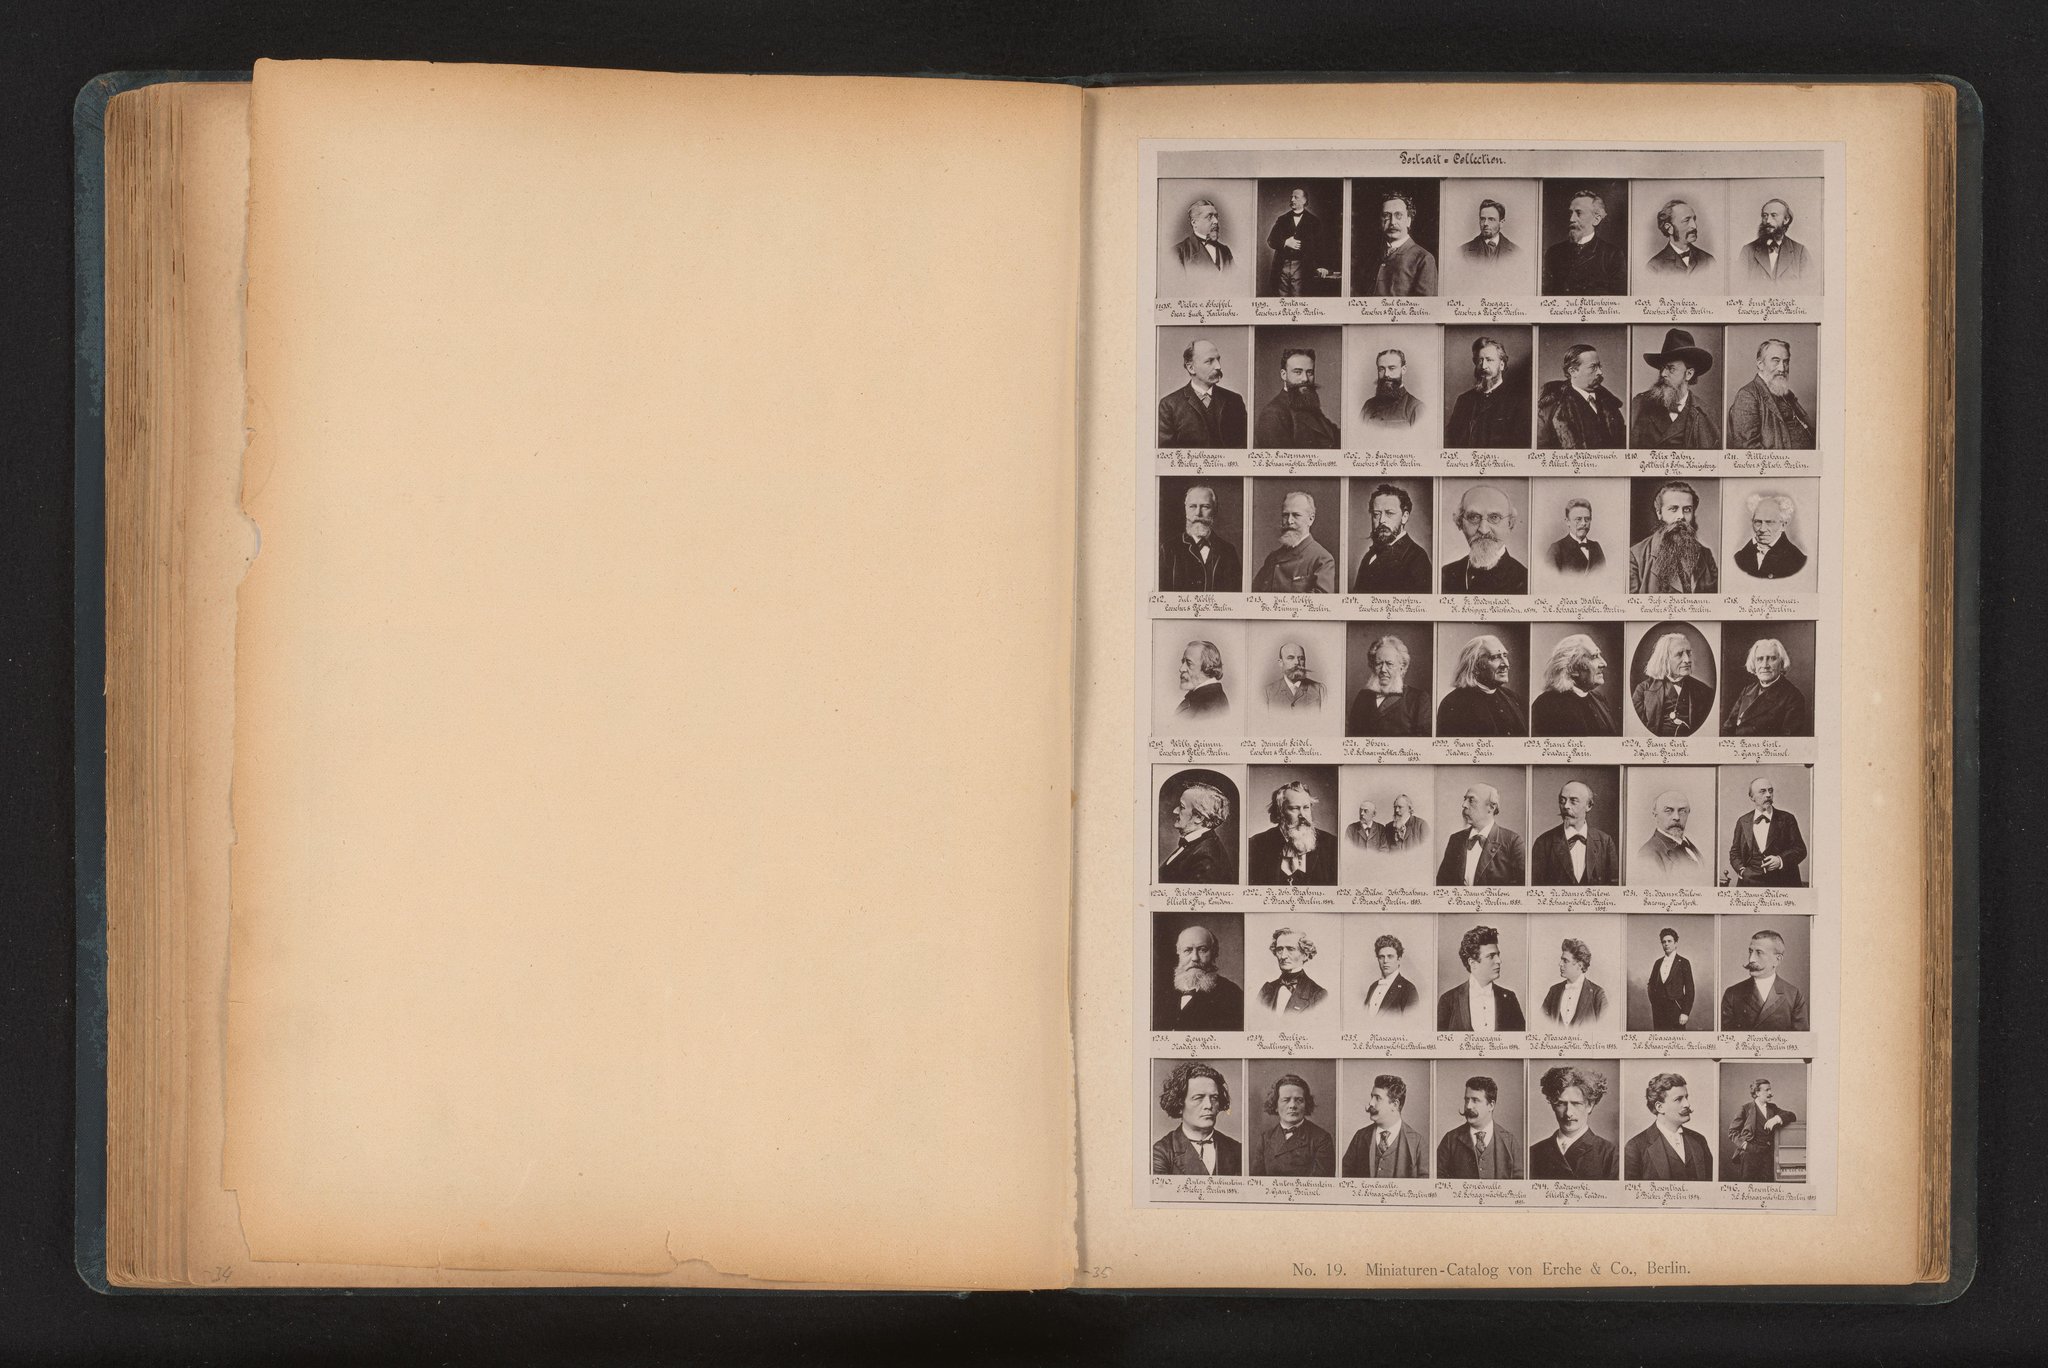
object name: page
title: Portretten van Duitse filosofen en componisten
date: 1880-1885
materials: paper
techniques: photograph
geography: berlin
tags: scholar, philosopher, portrait of a musician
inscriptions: number: ‘No. 19.’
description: Prent op vijfendertigste ongenummerde pagina.